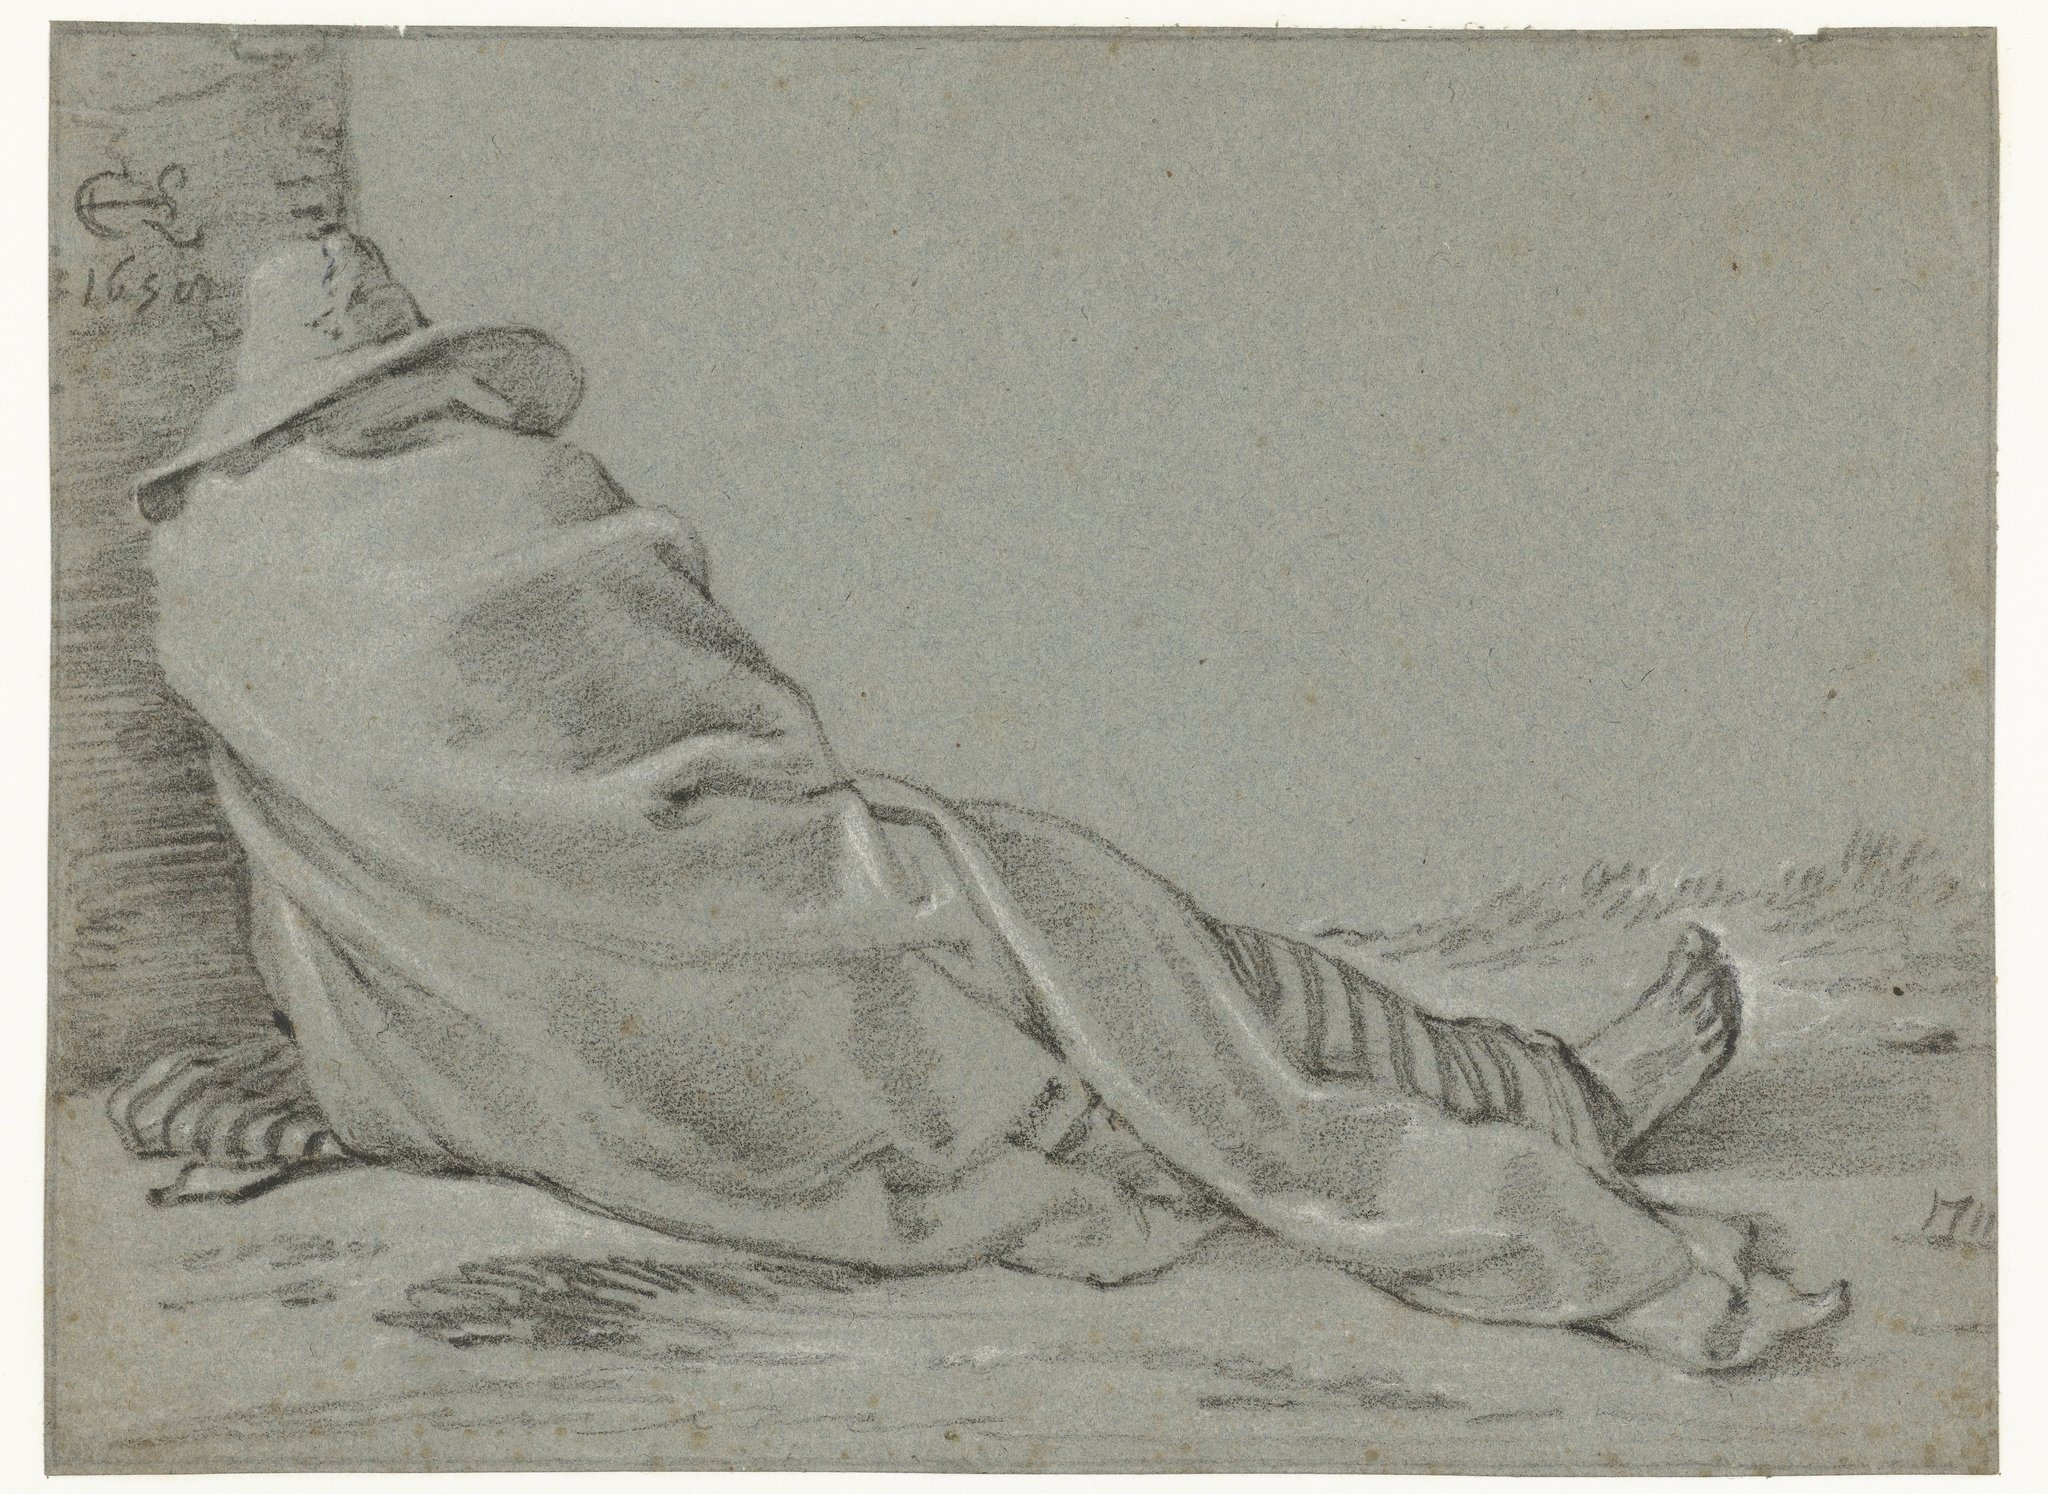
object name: drawing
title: Sleeping Man Leaning against a Wall, Wrapped in a Blanket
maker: cornelis saftleven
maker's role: draughtsman, painter, print maker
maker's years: 1607-1681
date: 1658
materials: chalk, paper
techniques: drawing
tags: sleeping on the ground, lying figure